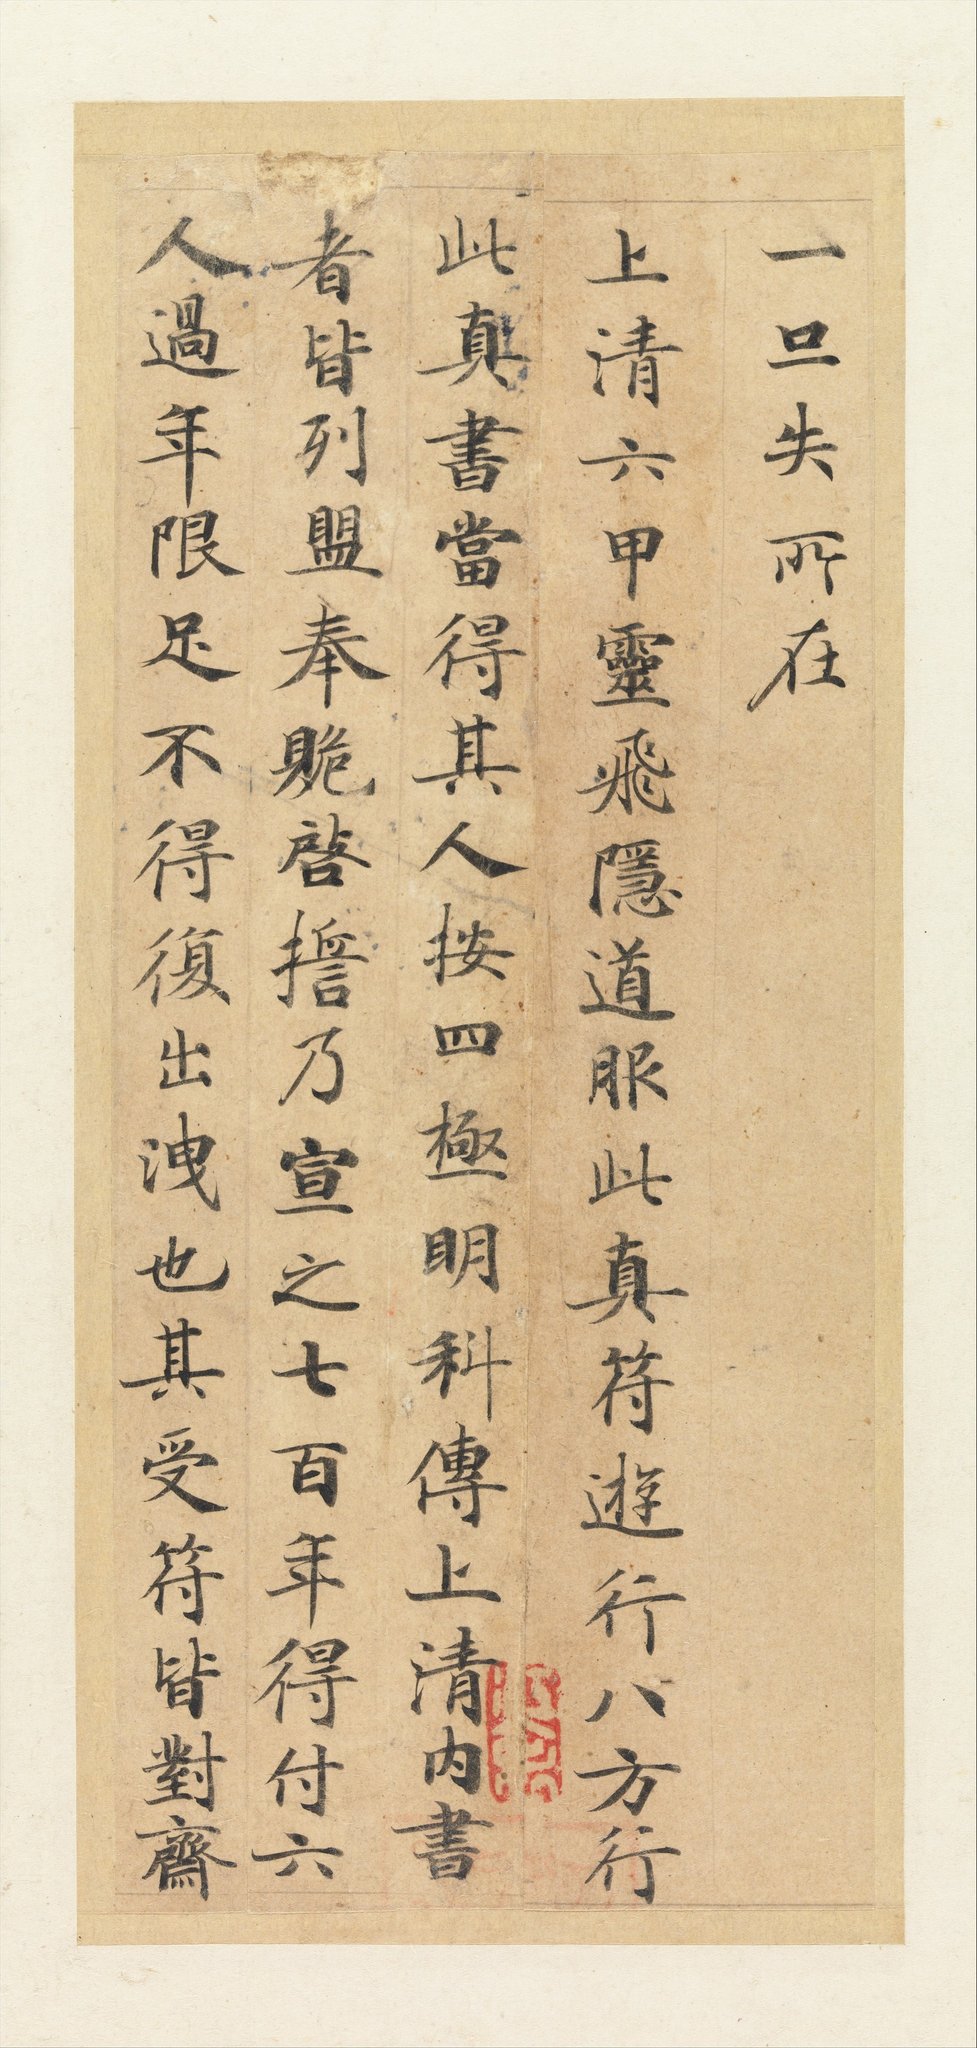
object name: album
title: Classic of Spiritual Flight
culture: chinese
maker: zhong shaojing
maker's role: artist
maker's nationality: chinese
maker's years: 713-741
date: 738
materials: ink, paper